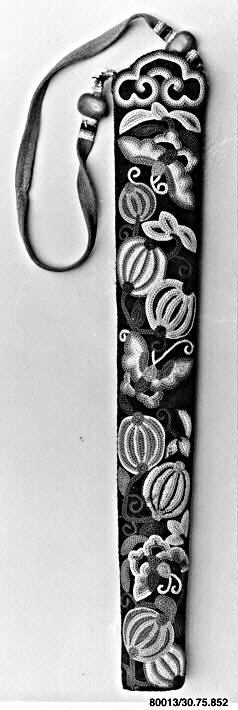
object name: fan holder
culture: chinese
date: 1701-1900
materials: silk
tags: butterflies